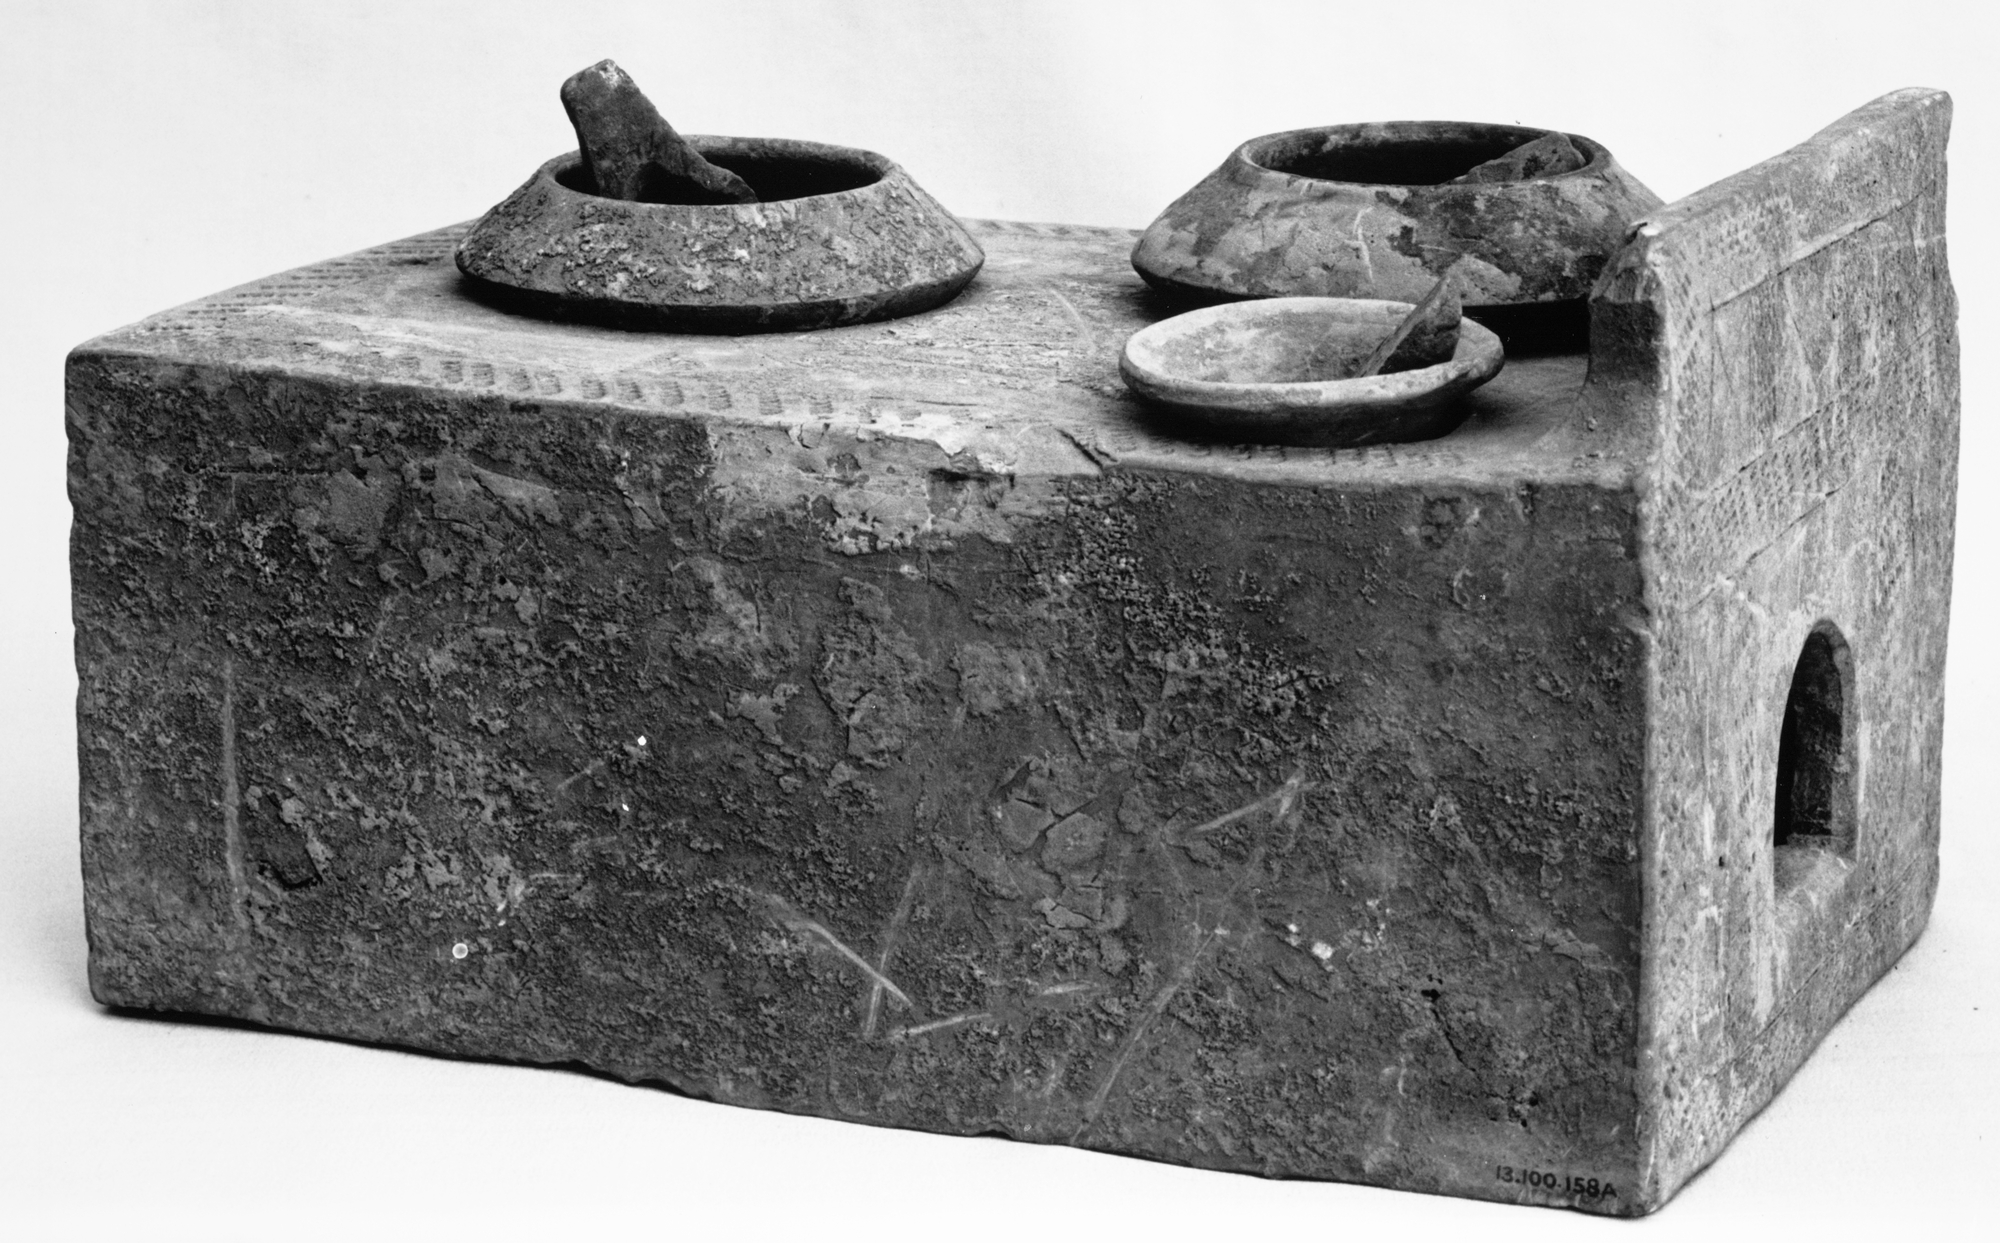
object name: stove model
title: Model of a Cooking Stove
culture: chinese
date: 206 BCE-220 CE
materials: pottery